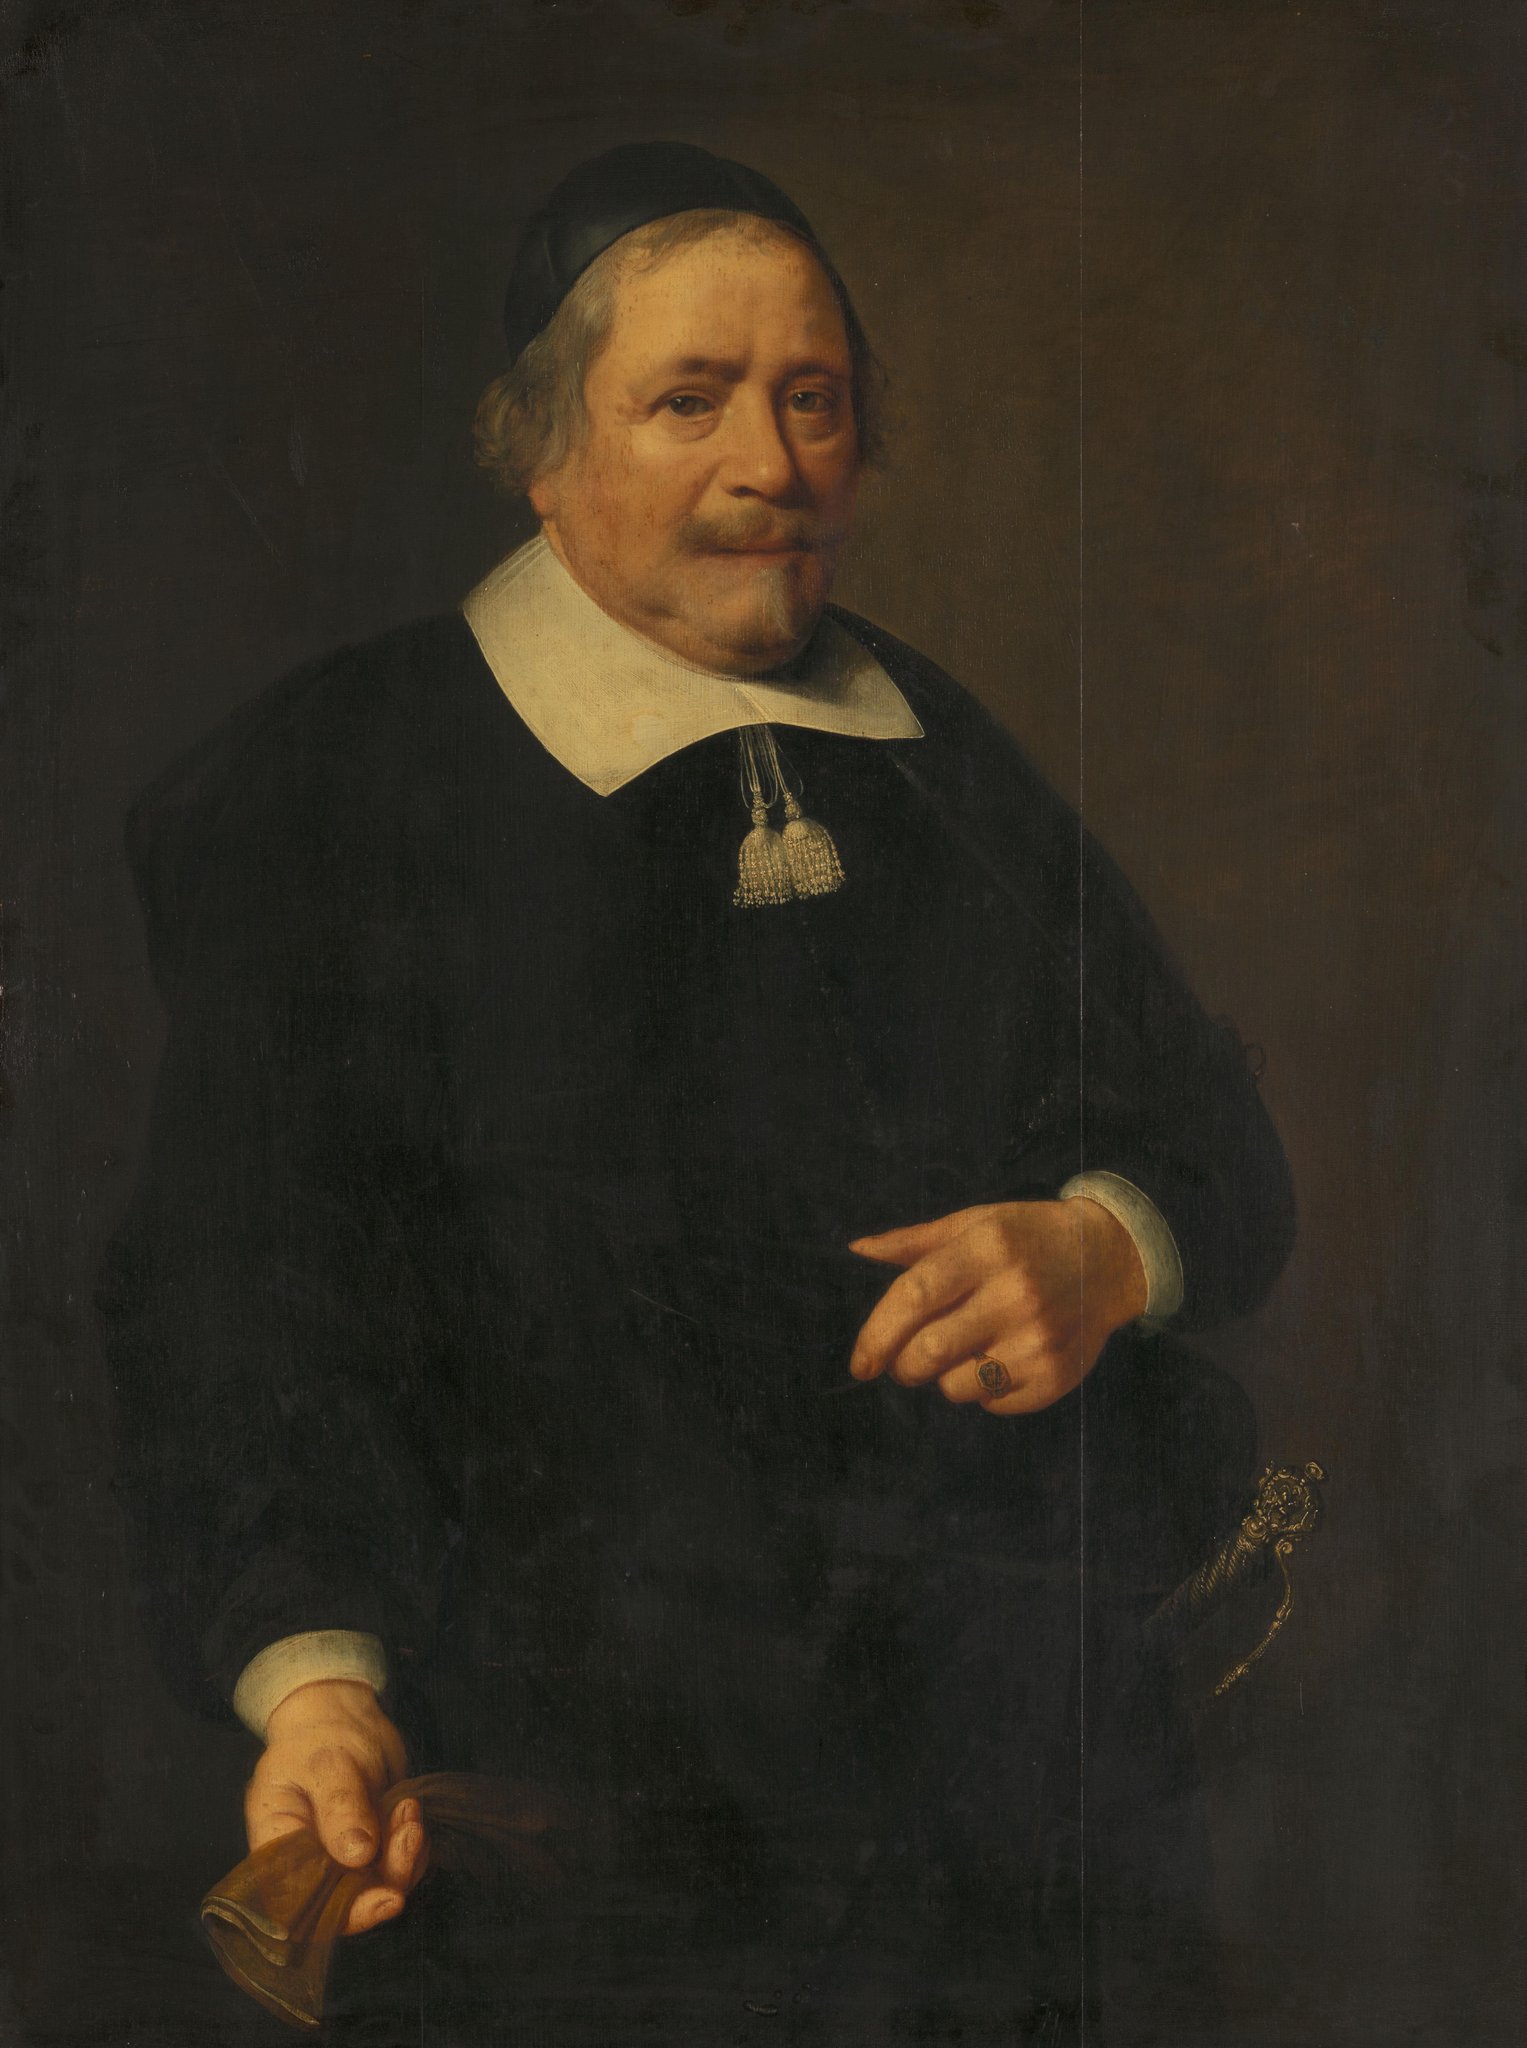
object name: painting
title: Portrait of a Man, presumably Willem Cornelisz. van Velden (1603-63)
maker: Anonymous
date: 1657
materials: oil, panel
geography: netherlands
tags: historical persons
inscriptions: inscription and date: ‘Aetatis 57 ANº 1657’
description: Portret van een man, vermoedelijk Willem Cornelisz. van Velden (1603-63), ten halven lijve, staand met handschoenen in de rechterhand. Van Velden was de vroegere dienaar van Hugo de Groot. Hij werd in 1625 beëdigd als notaris en in 1642 benoemd tot advocaat. In 1625 trouwde hij met Elsje van Houwelingen (zie pendant, SK-A-584), de dienstmeid van Maria van Reigersberch en Hugo de Groot, die een belangrijke rol had gespeeld bij De Groots ontsnapping uit Loevestein in 1621.